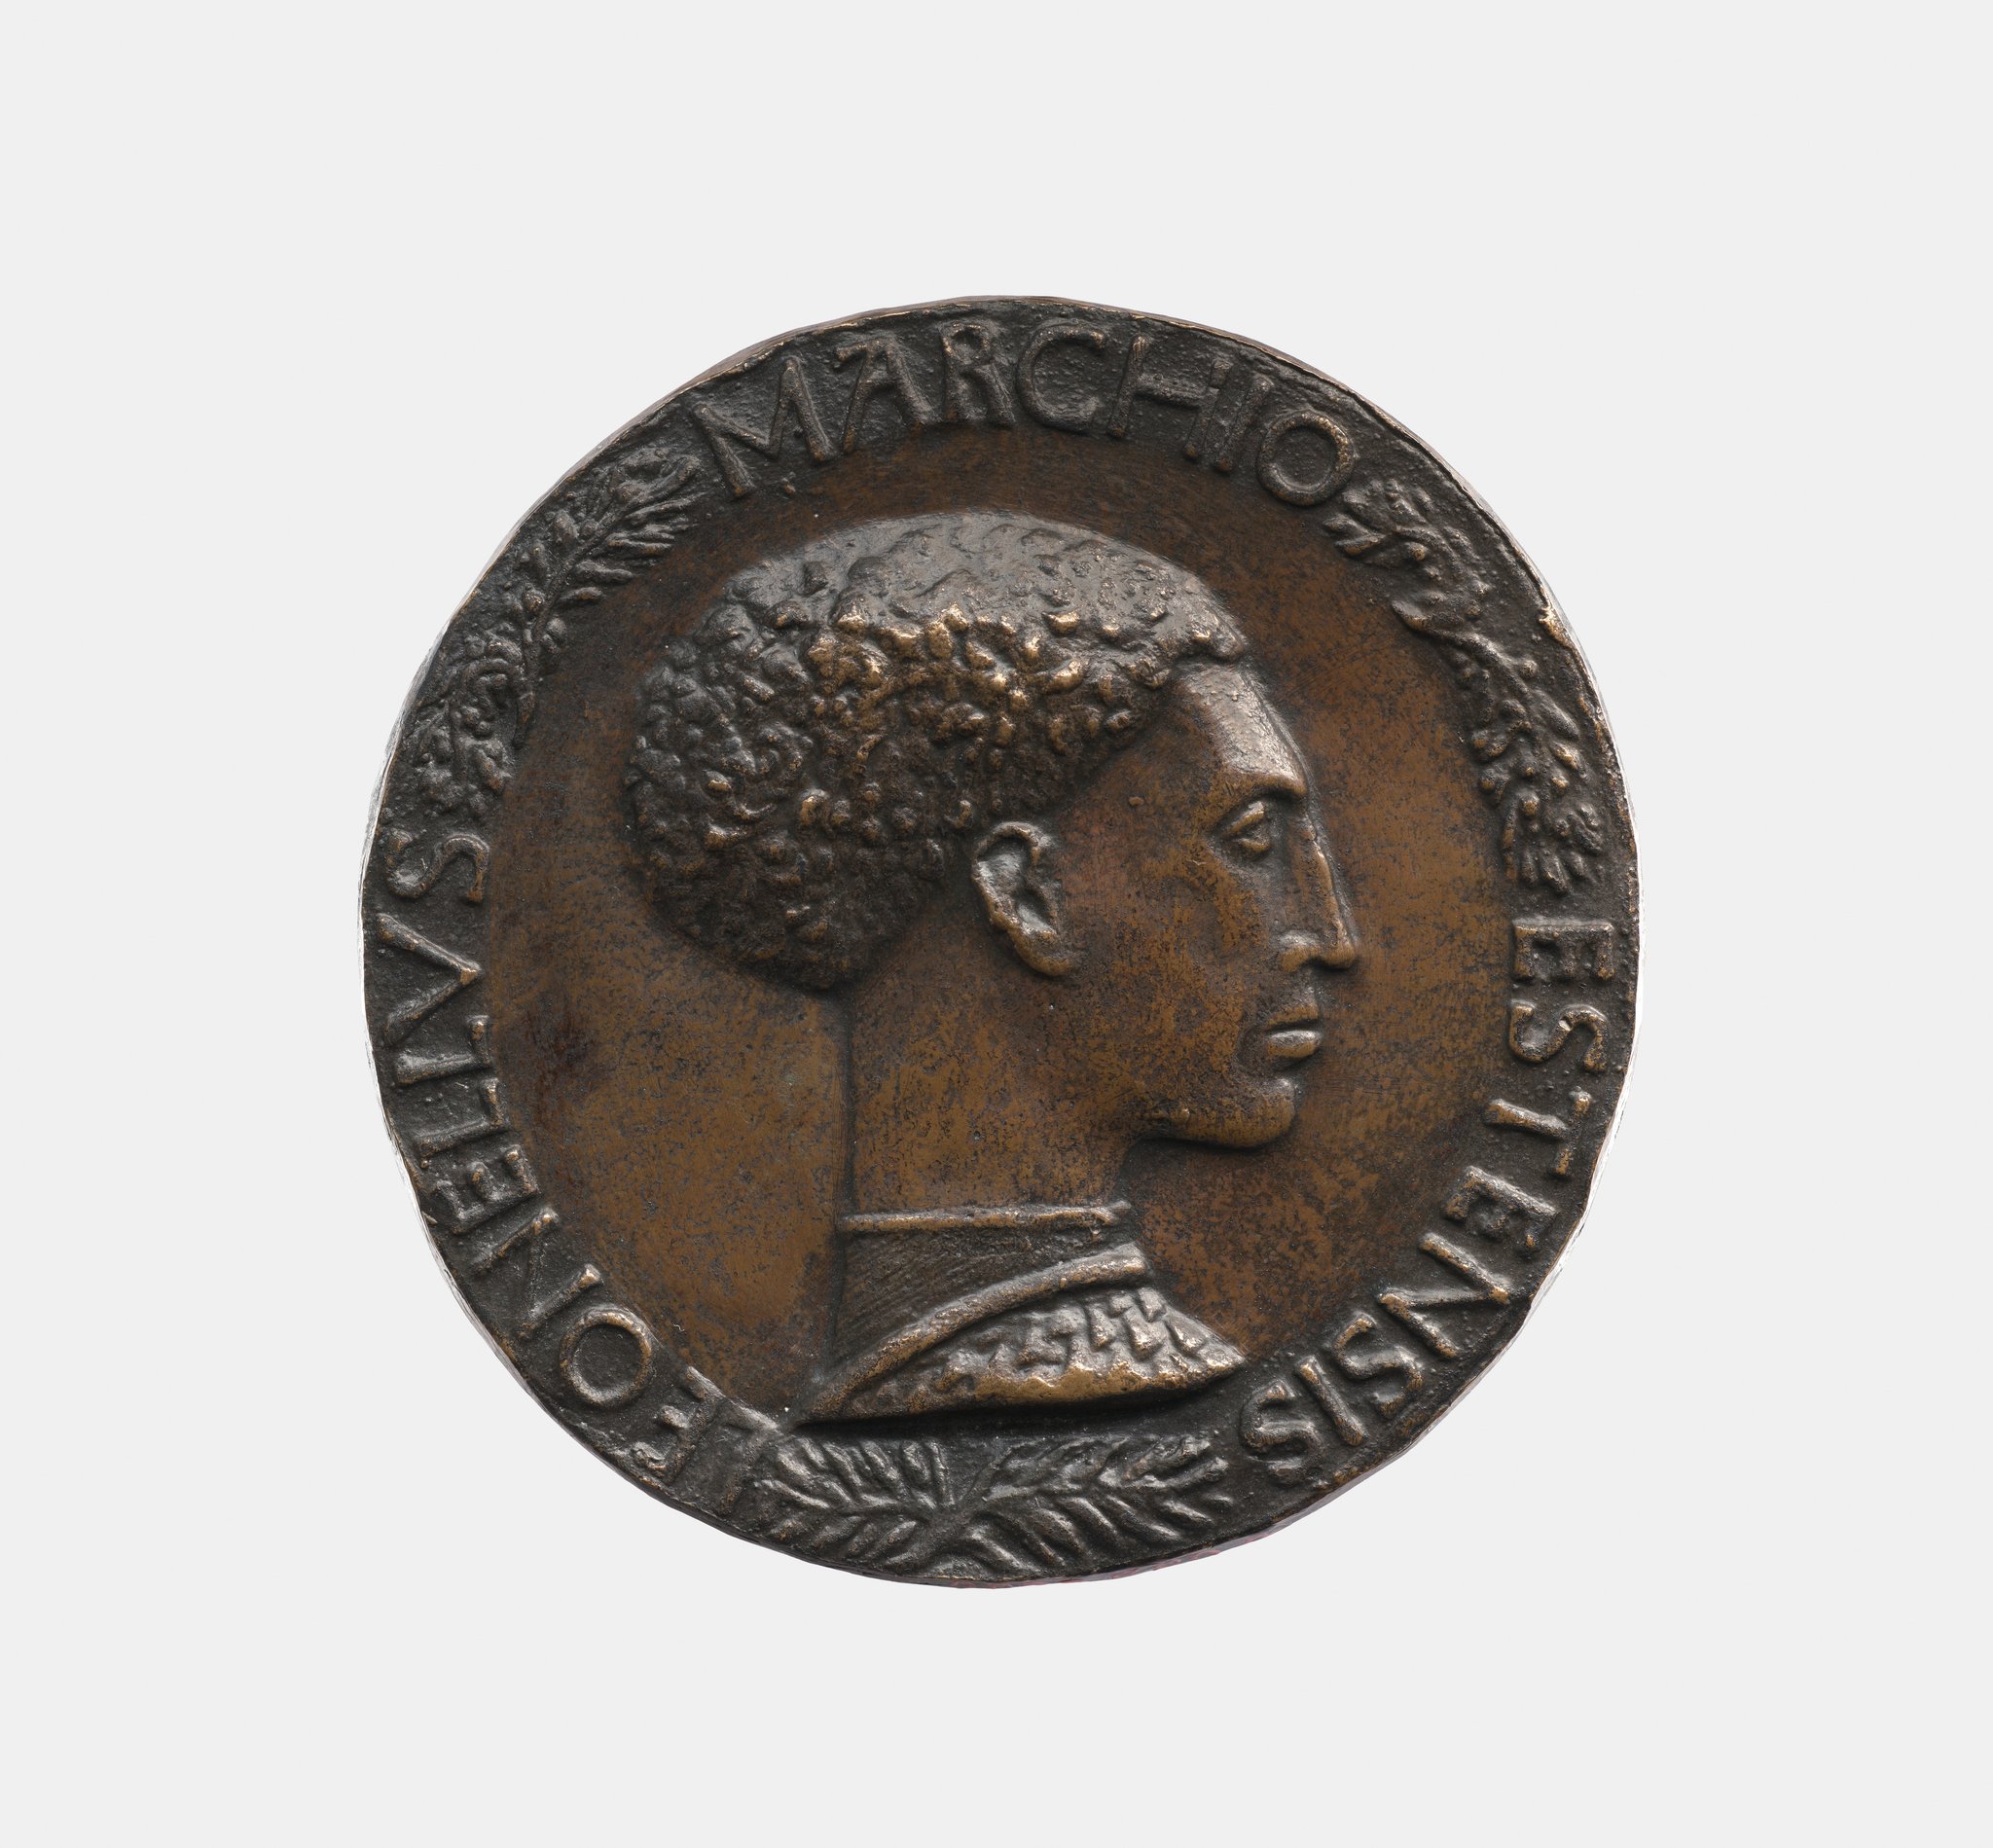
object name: medal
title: Leonello d'Este 1407-50, Marquis of Ferrara 1441-50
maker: pisanello (antonio pisano)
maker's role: artist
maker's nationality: italian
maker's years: 1395-1455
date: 1438-1449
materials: bronze